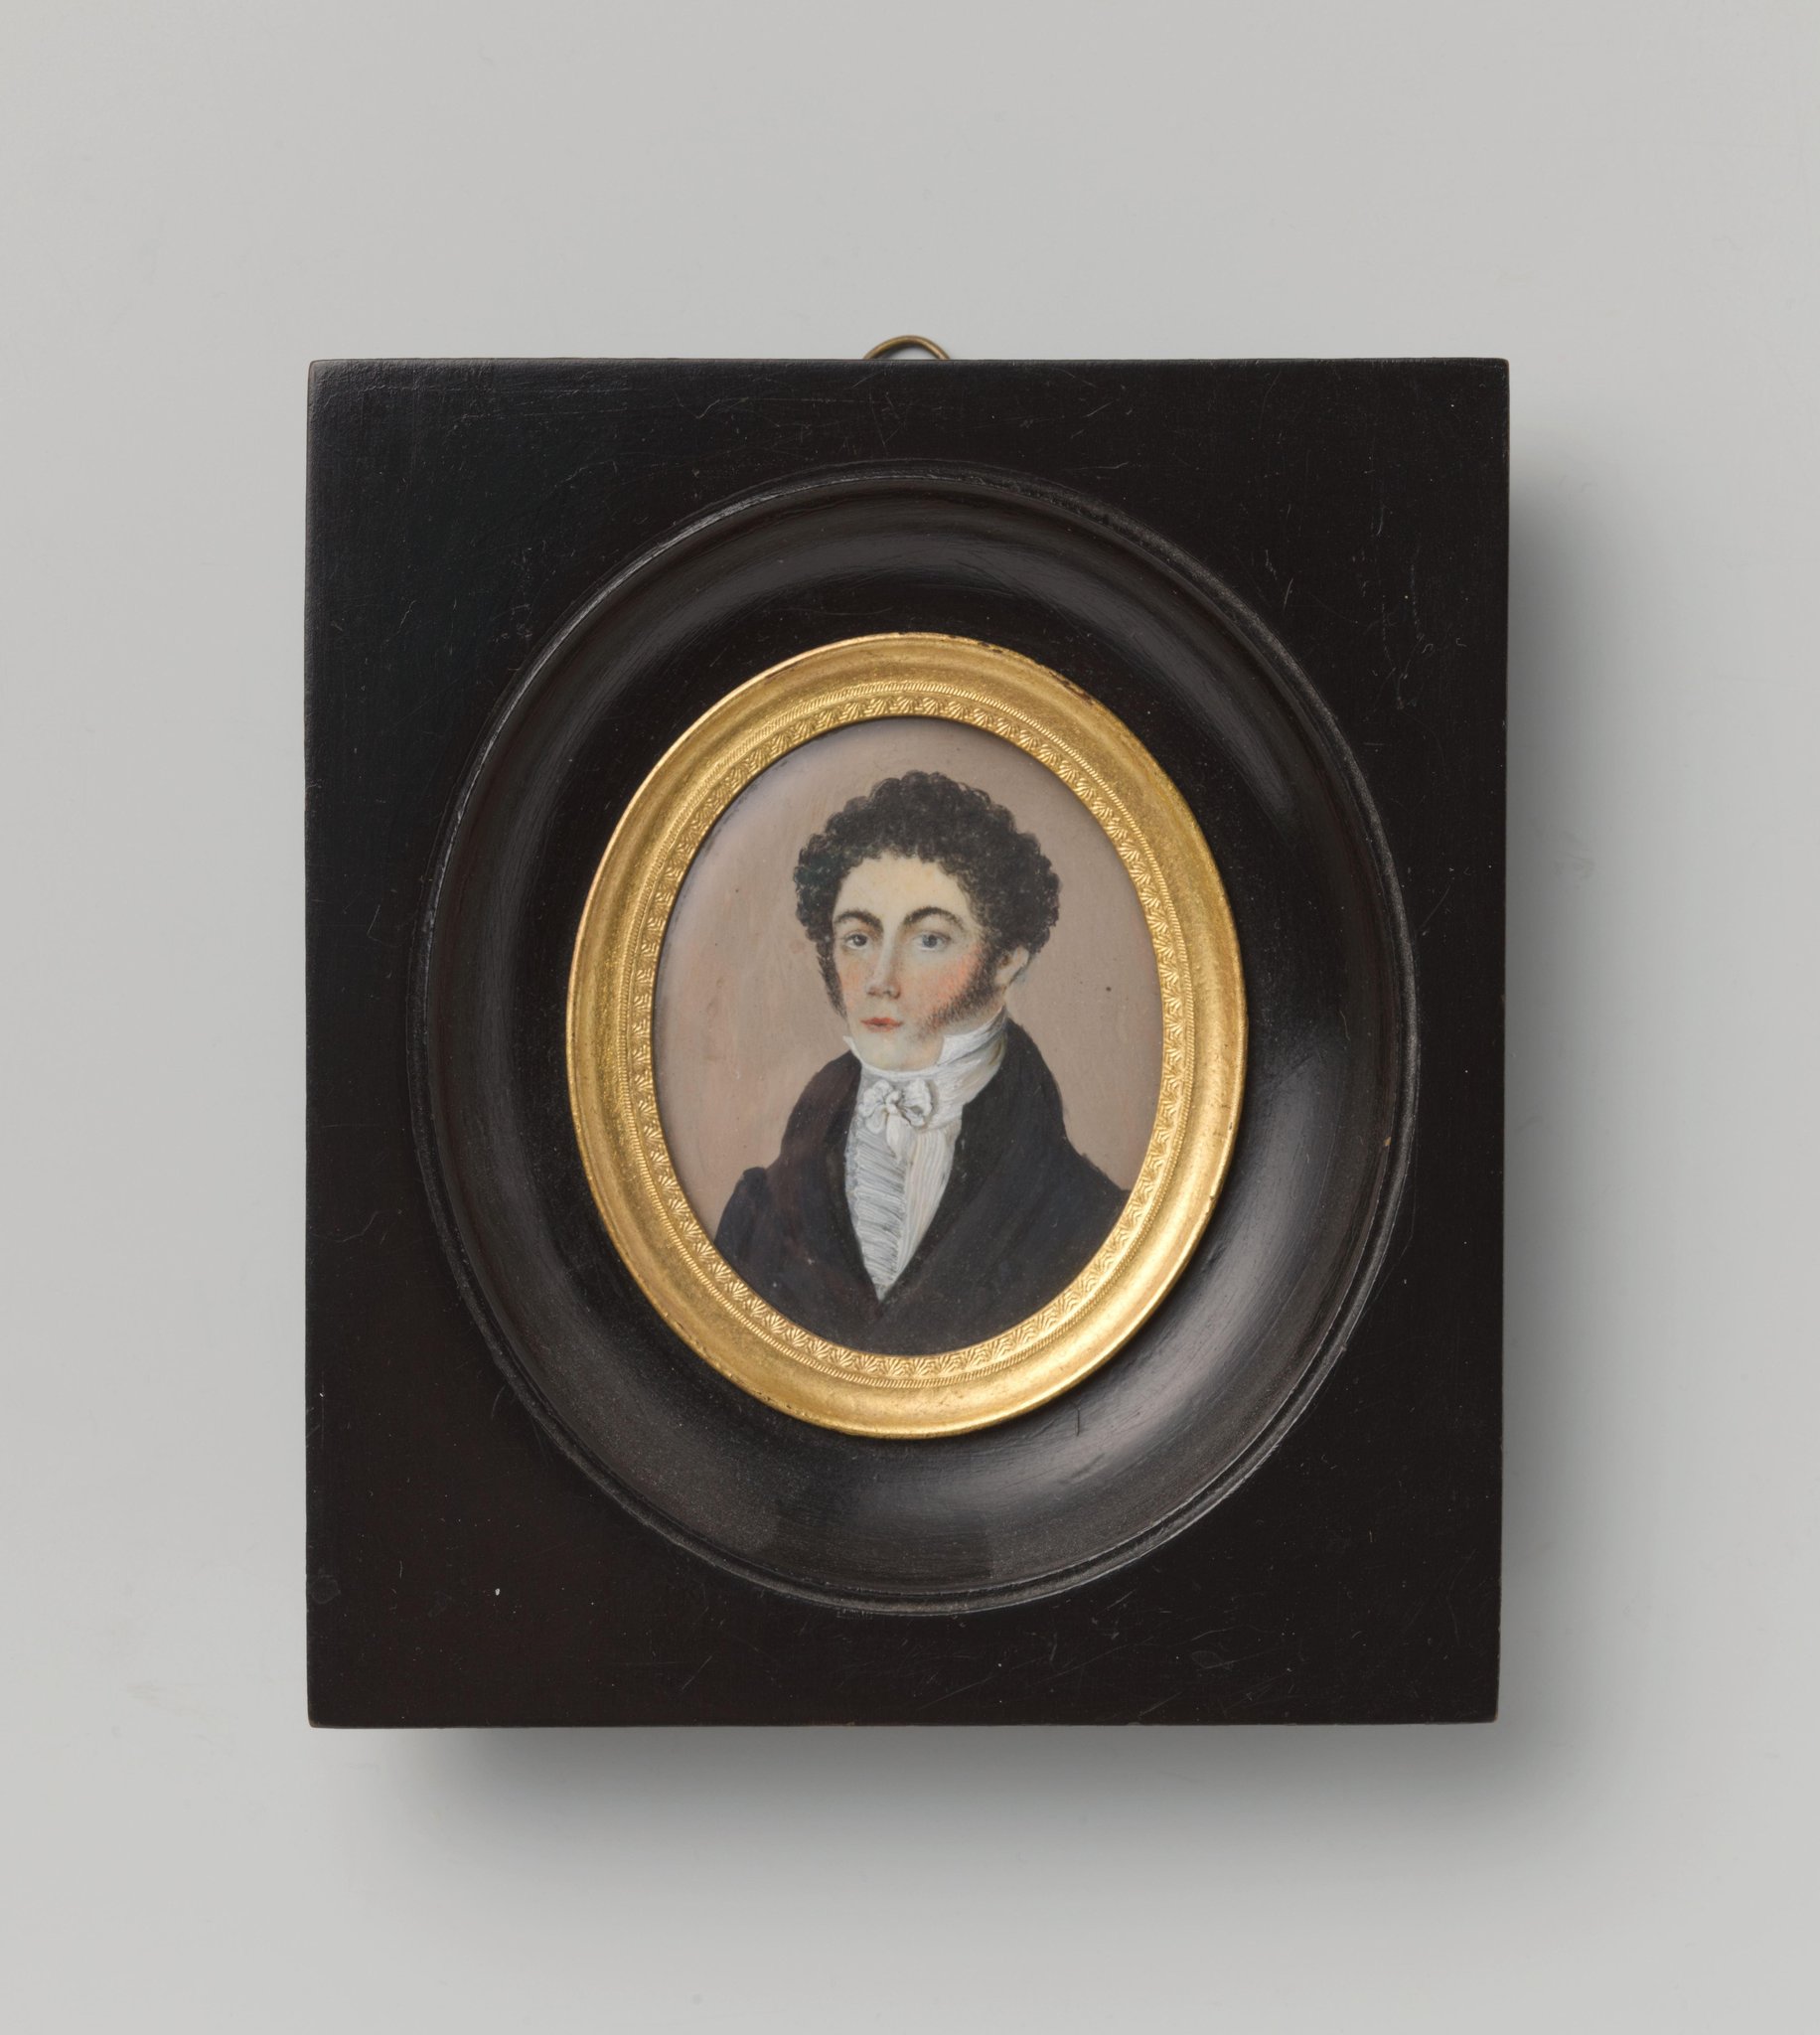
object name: painting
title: Hendrik Maurits Wolf de Friderici (1818-1841)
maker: Anonymous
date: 1838-1900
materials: oil, paint, paper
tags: suriname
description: Schilderij in lijst van zwart hout met sierlijst van latoenkoper.